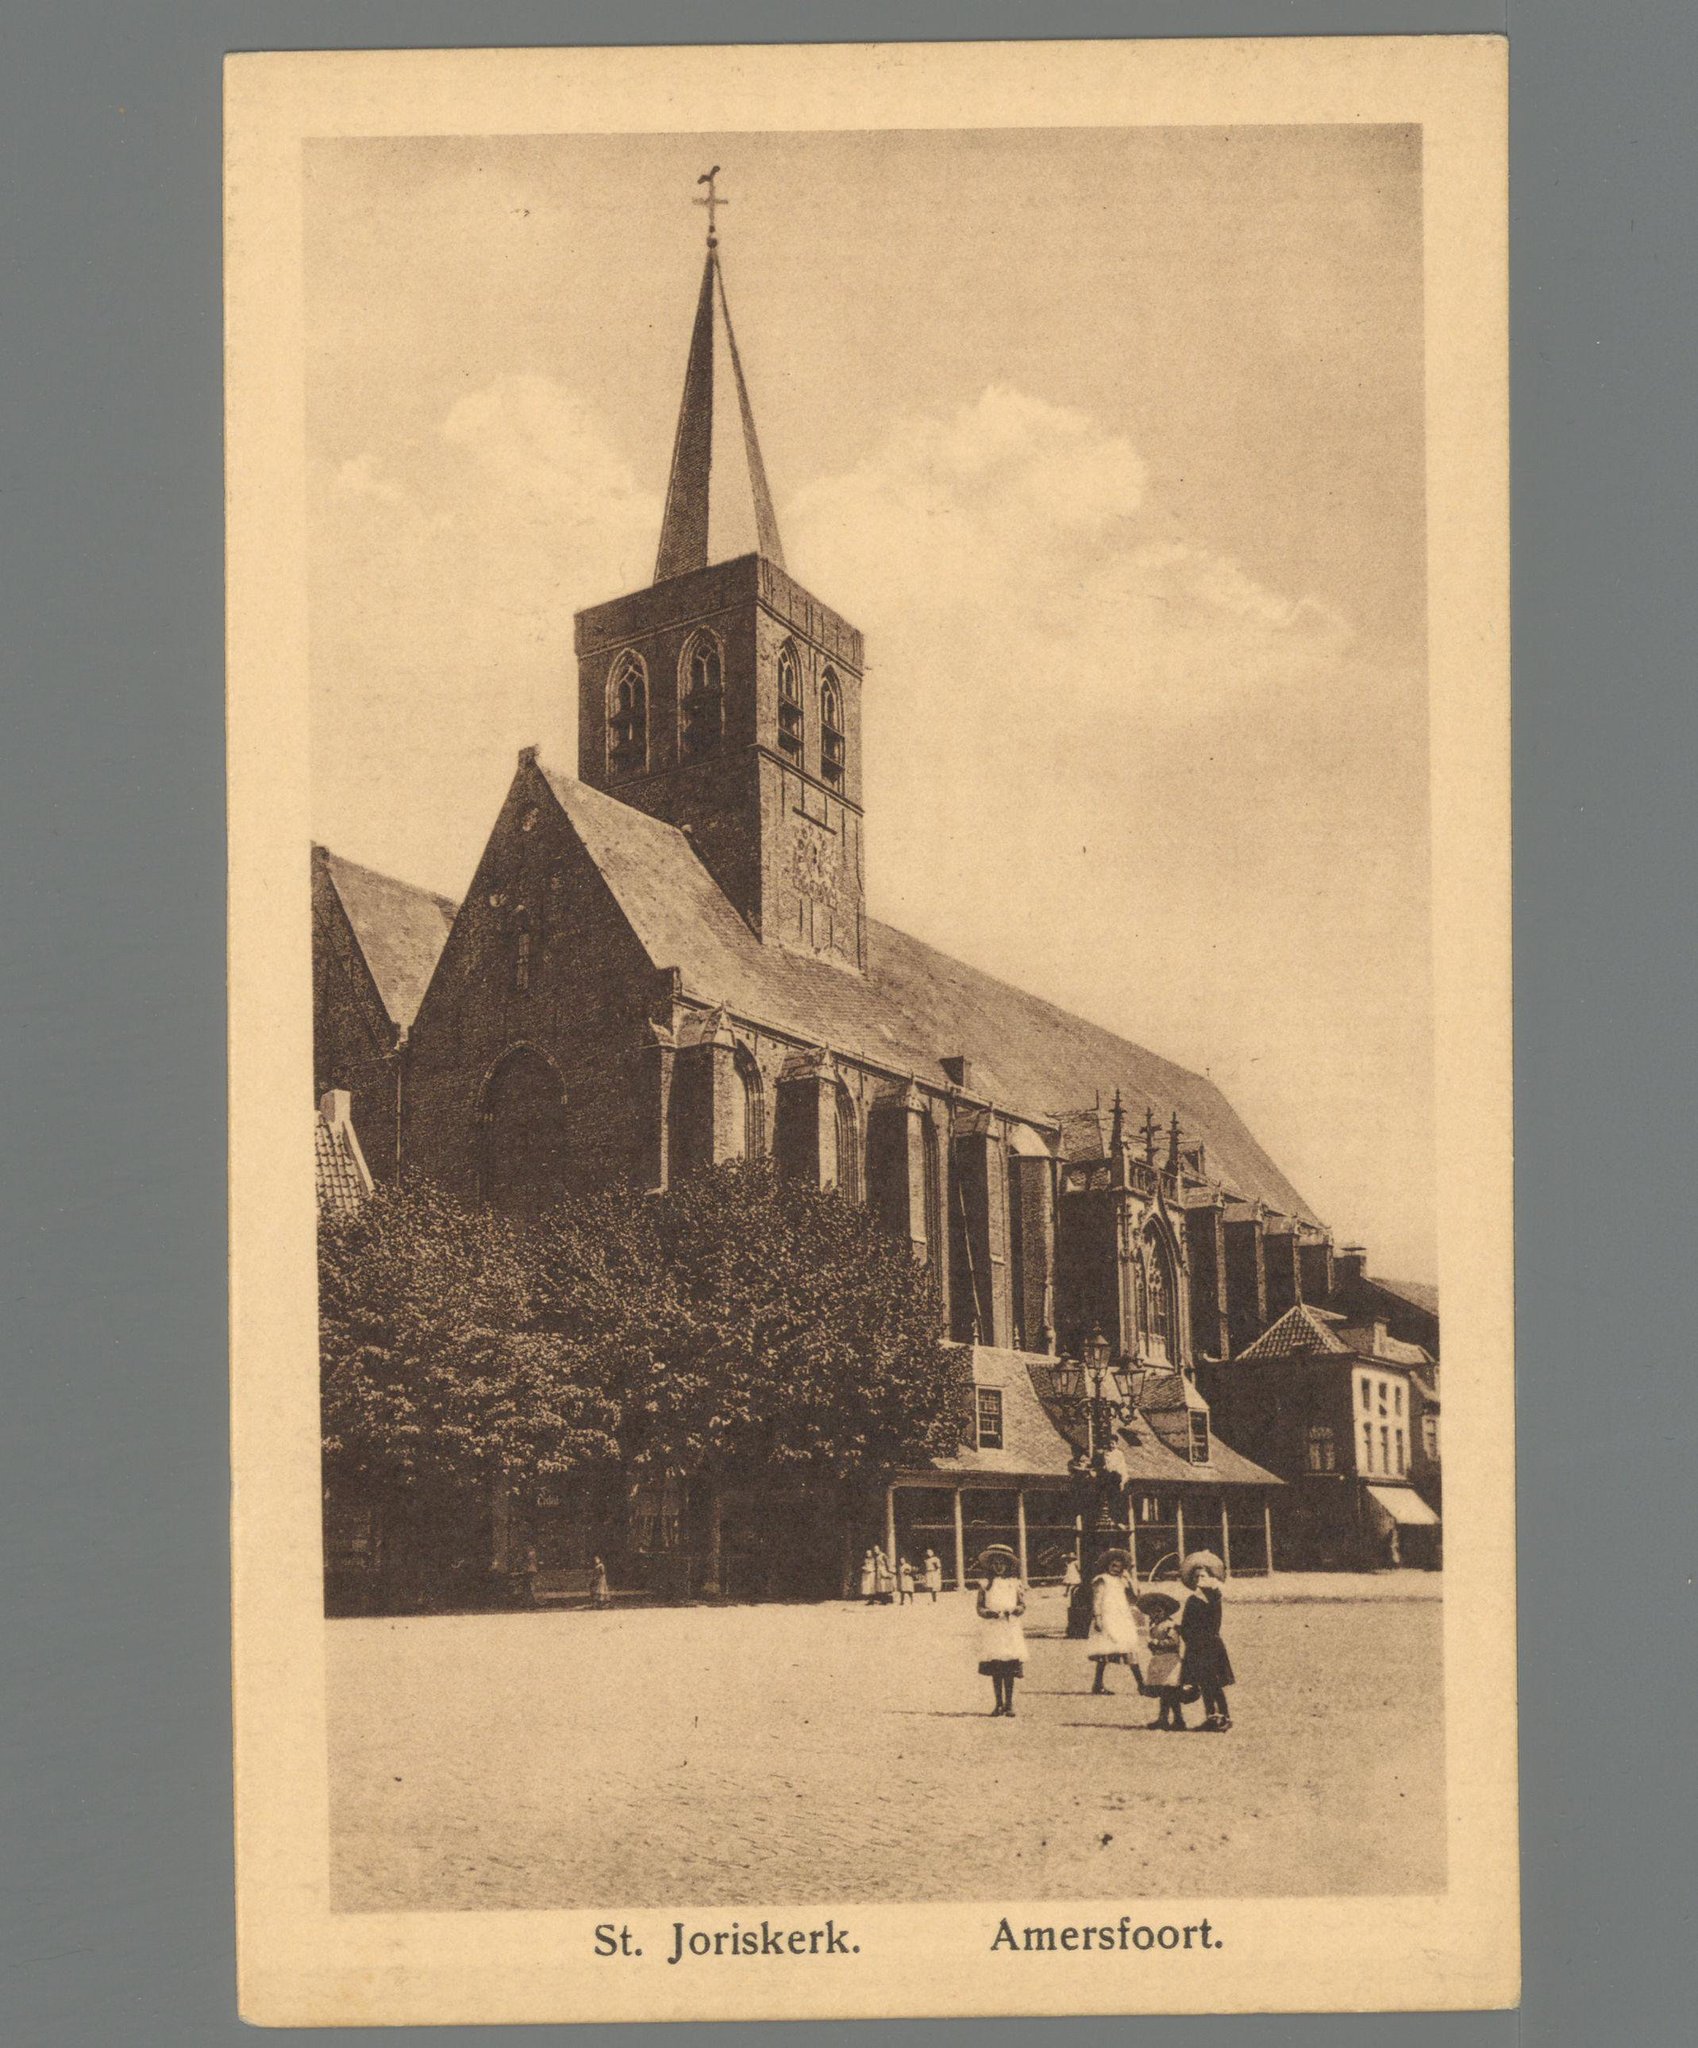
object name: ansichtkaart, prentbriefkaart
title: St. Joriskerk. Amersfoort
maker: Anonymous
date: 1913-1930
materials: cardboard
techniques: photograph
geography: amersfoort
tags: church (exterior)